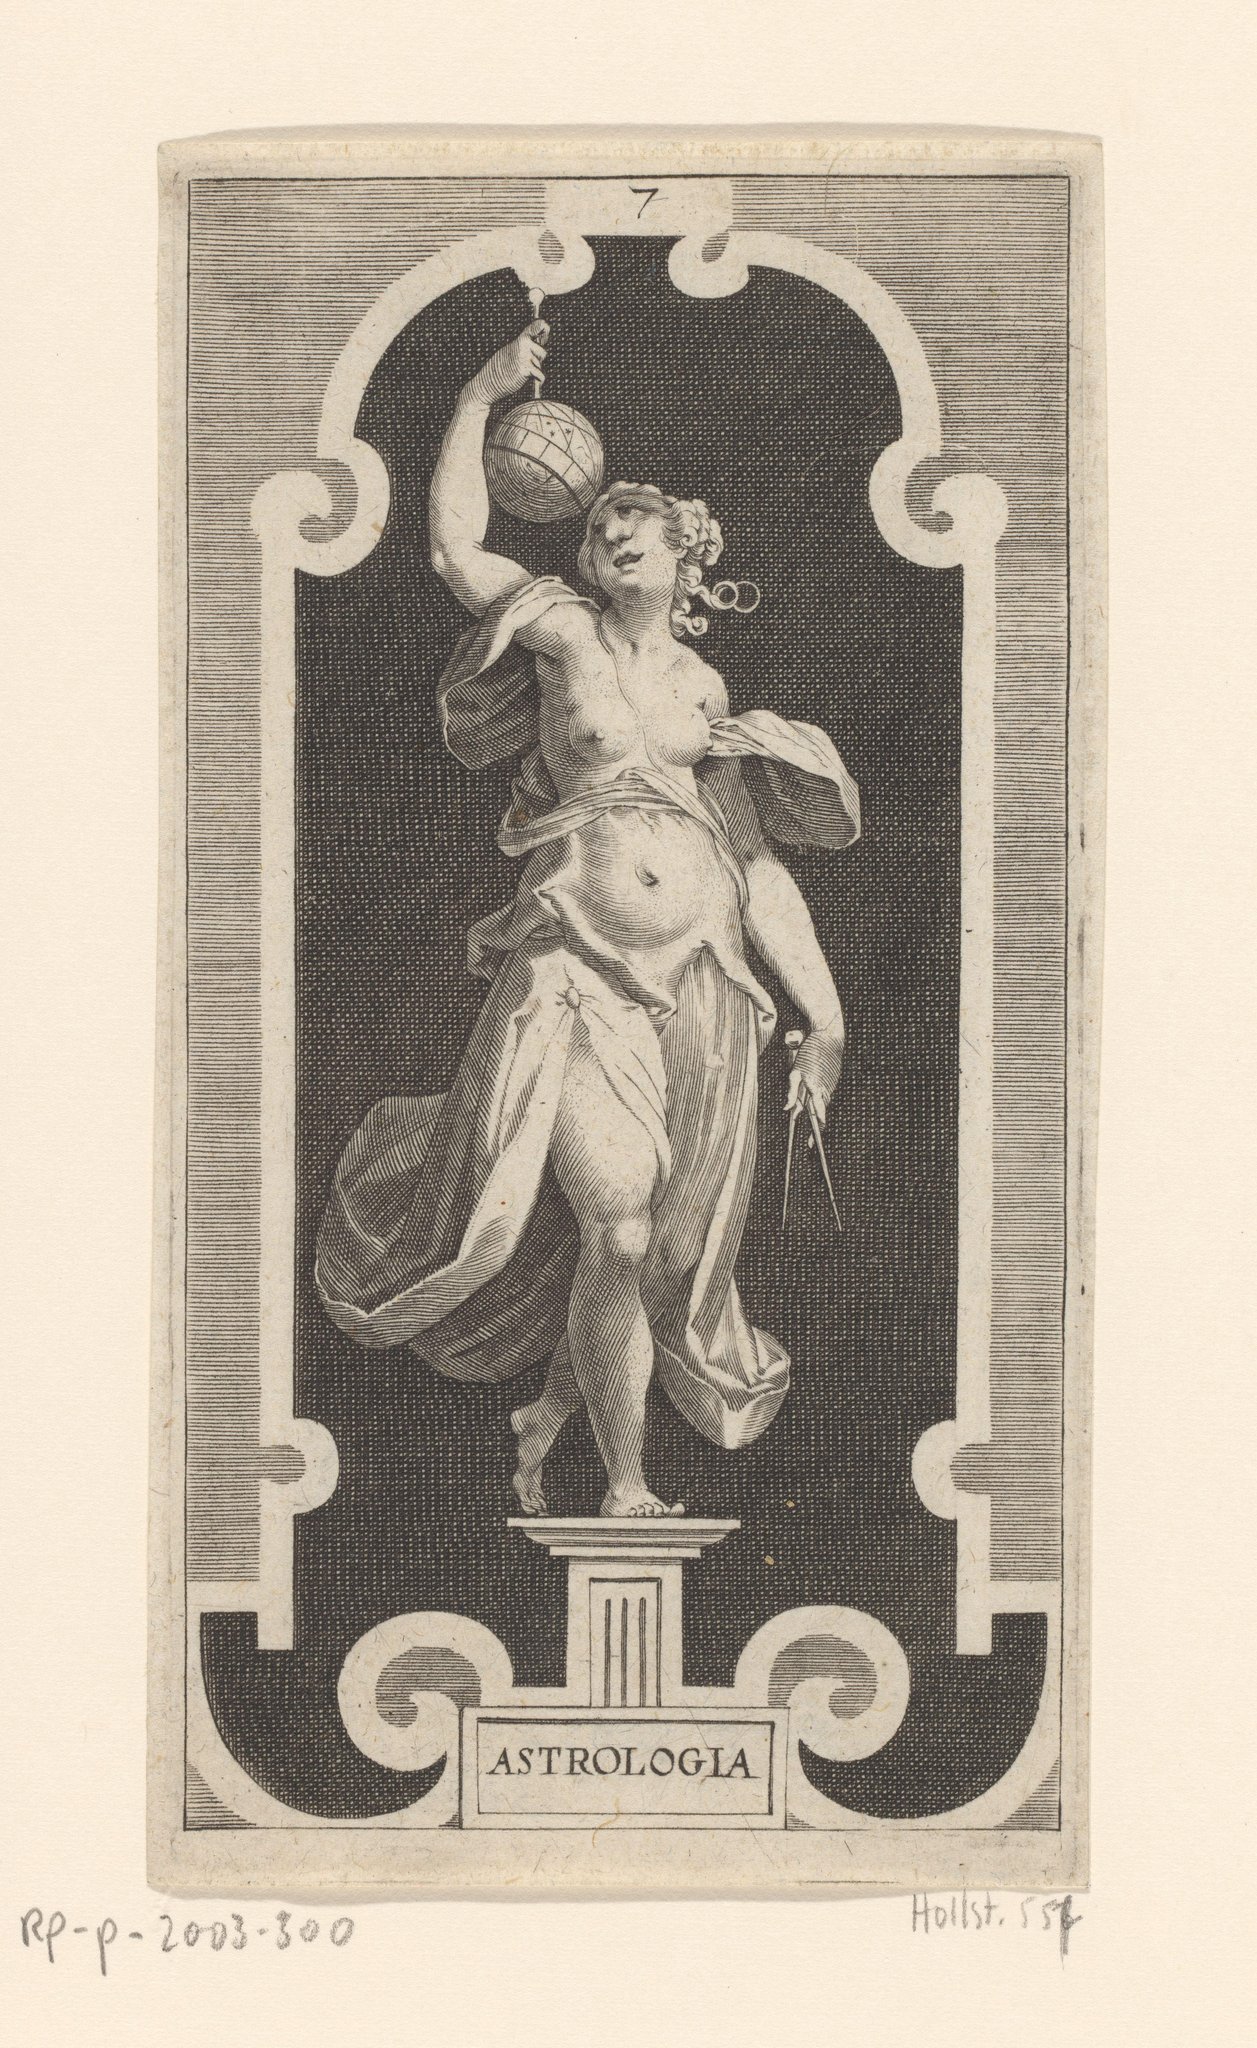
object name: print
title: Zeven Vrij Kunsten in beeld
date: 1640-1708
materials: paper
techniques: engraving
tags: the liberal arts, 'artes liberales', 'astronomia' (~ quadrivium); 'astronomia' (ripa), 'astrologia' (ripa)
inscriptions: collector's mark: Lugt 2228, collector's mark: Lugt 2760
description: Deze prent hoort bij een serie van zeven prenten met personificaties van Zeven Vrij Kunsten.